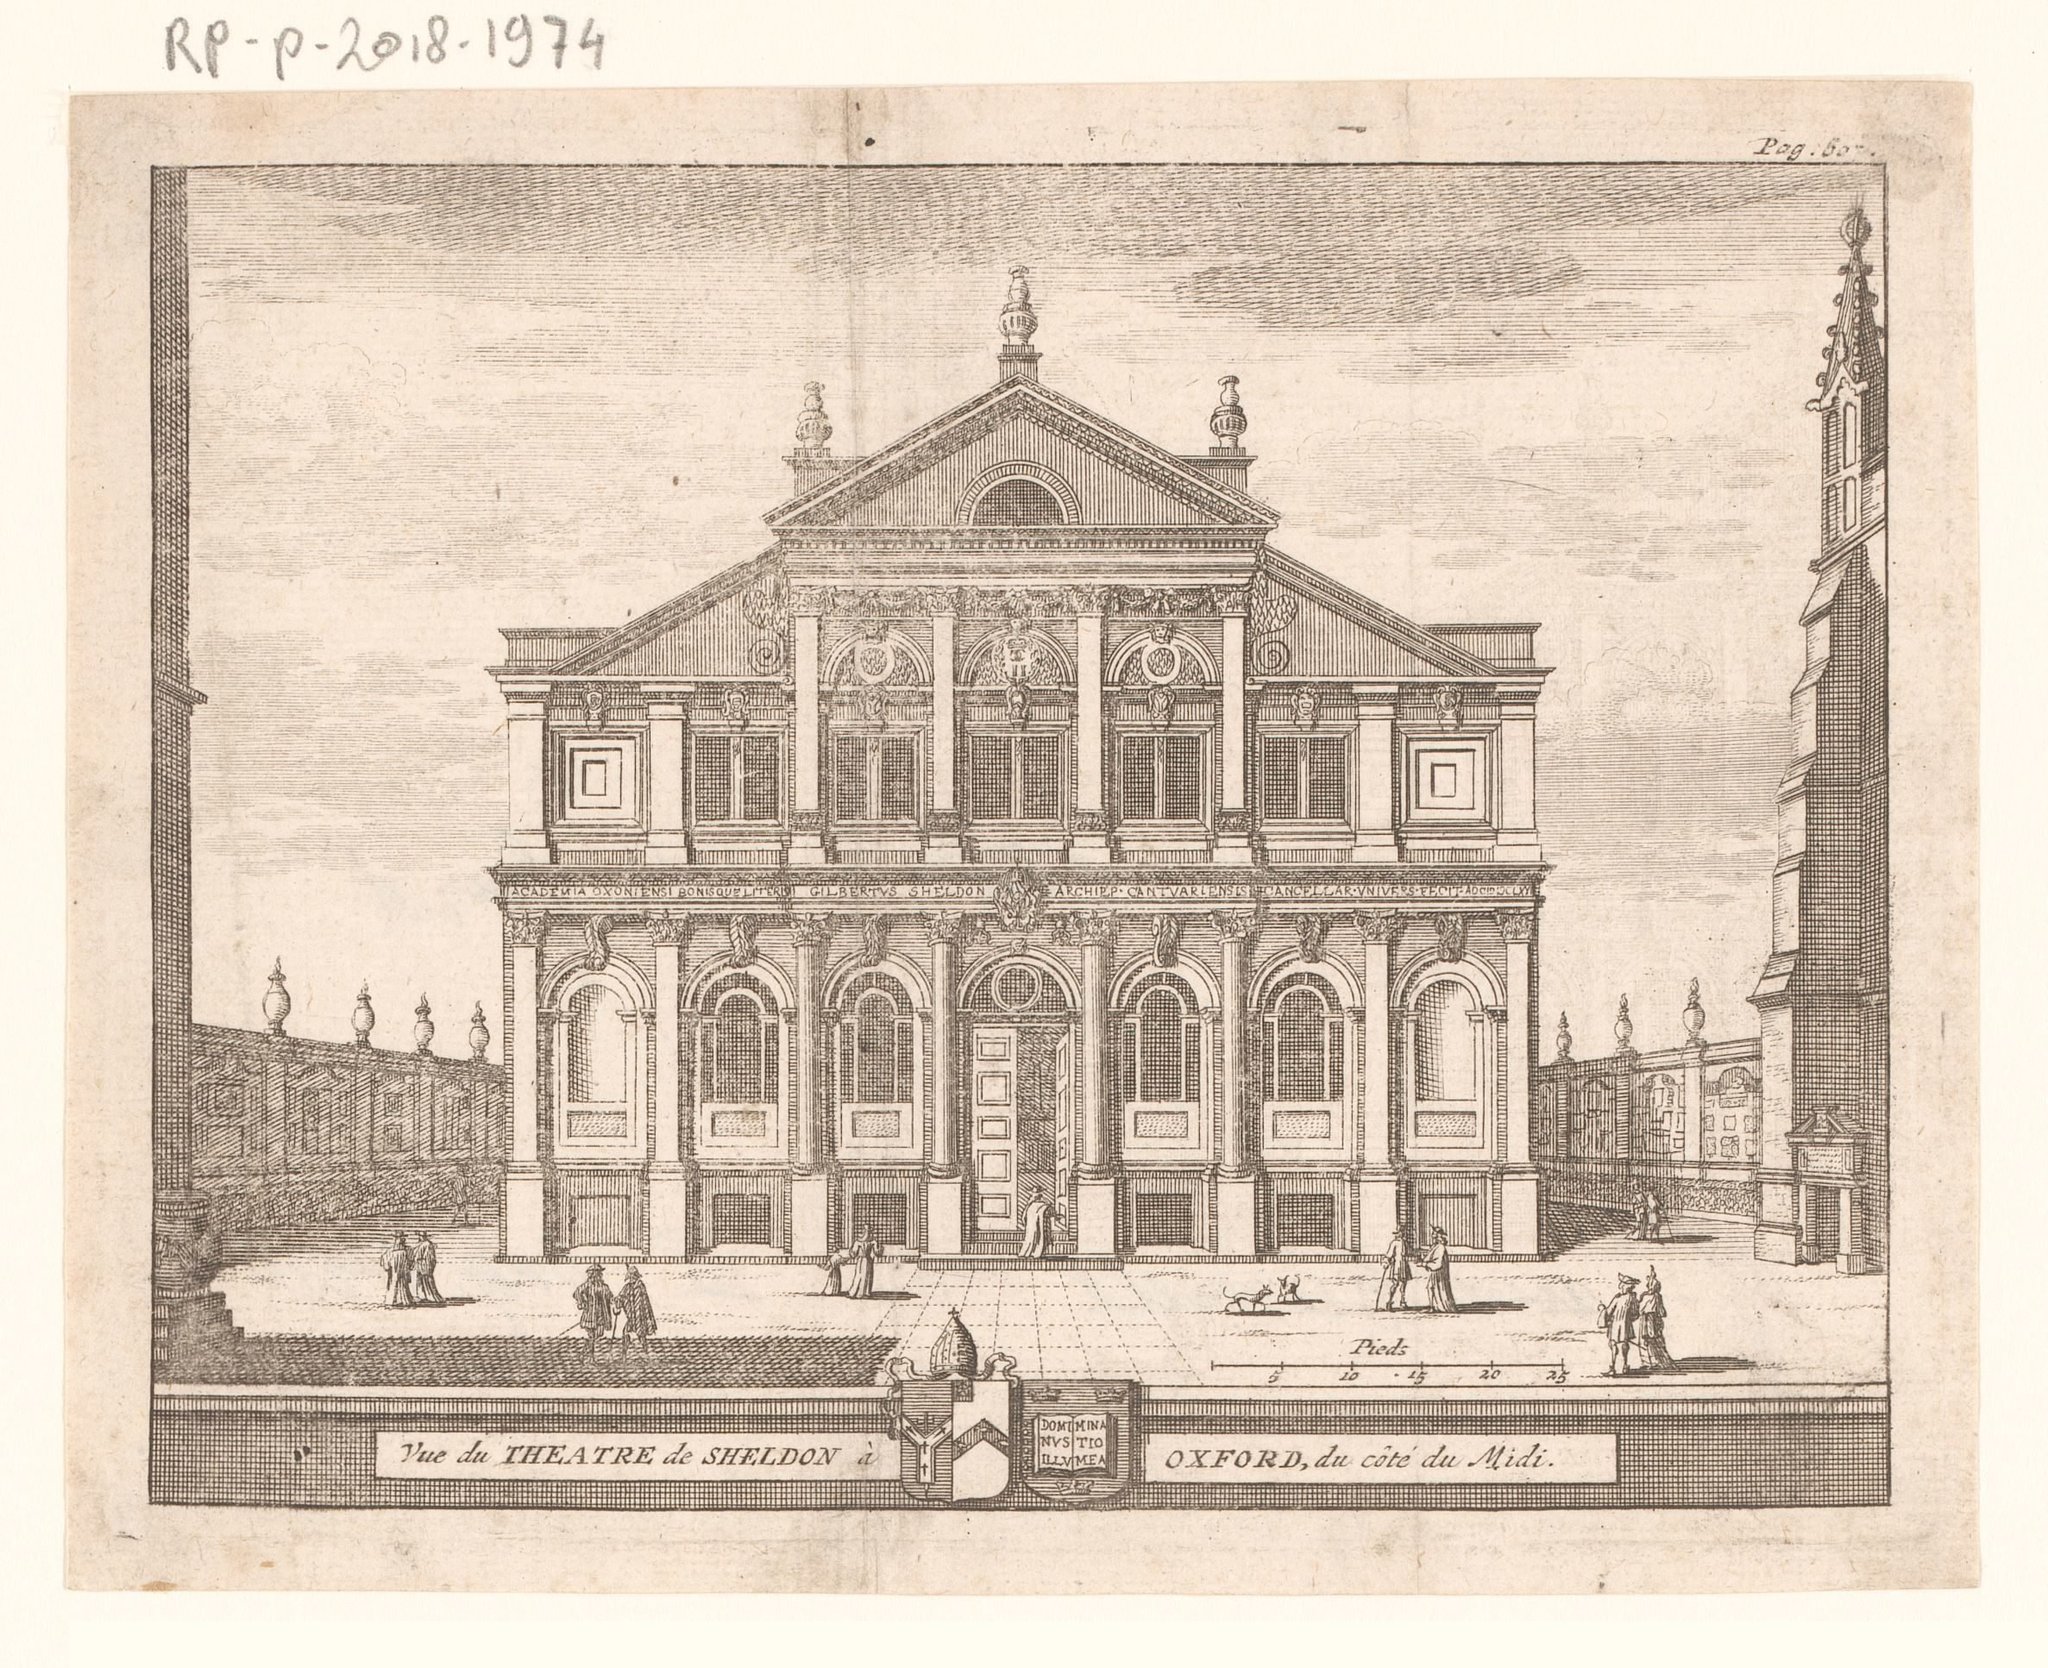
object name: print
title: Gezicht op het Sheldonian Theatre, te Oxford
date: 1707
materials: paper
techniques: etching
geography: leiden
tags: theatre (building)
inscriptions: collector's mark: Lugt 2228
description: Prent gebruikt in: Beeverell, James. Les Delices de la Grande Bretagne et de l'Irlande (...). Leiden: Pieter van der Aa, 1707.